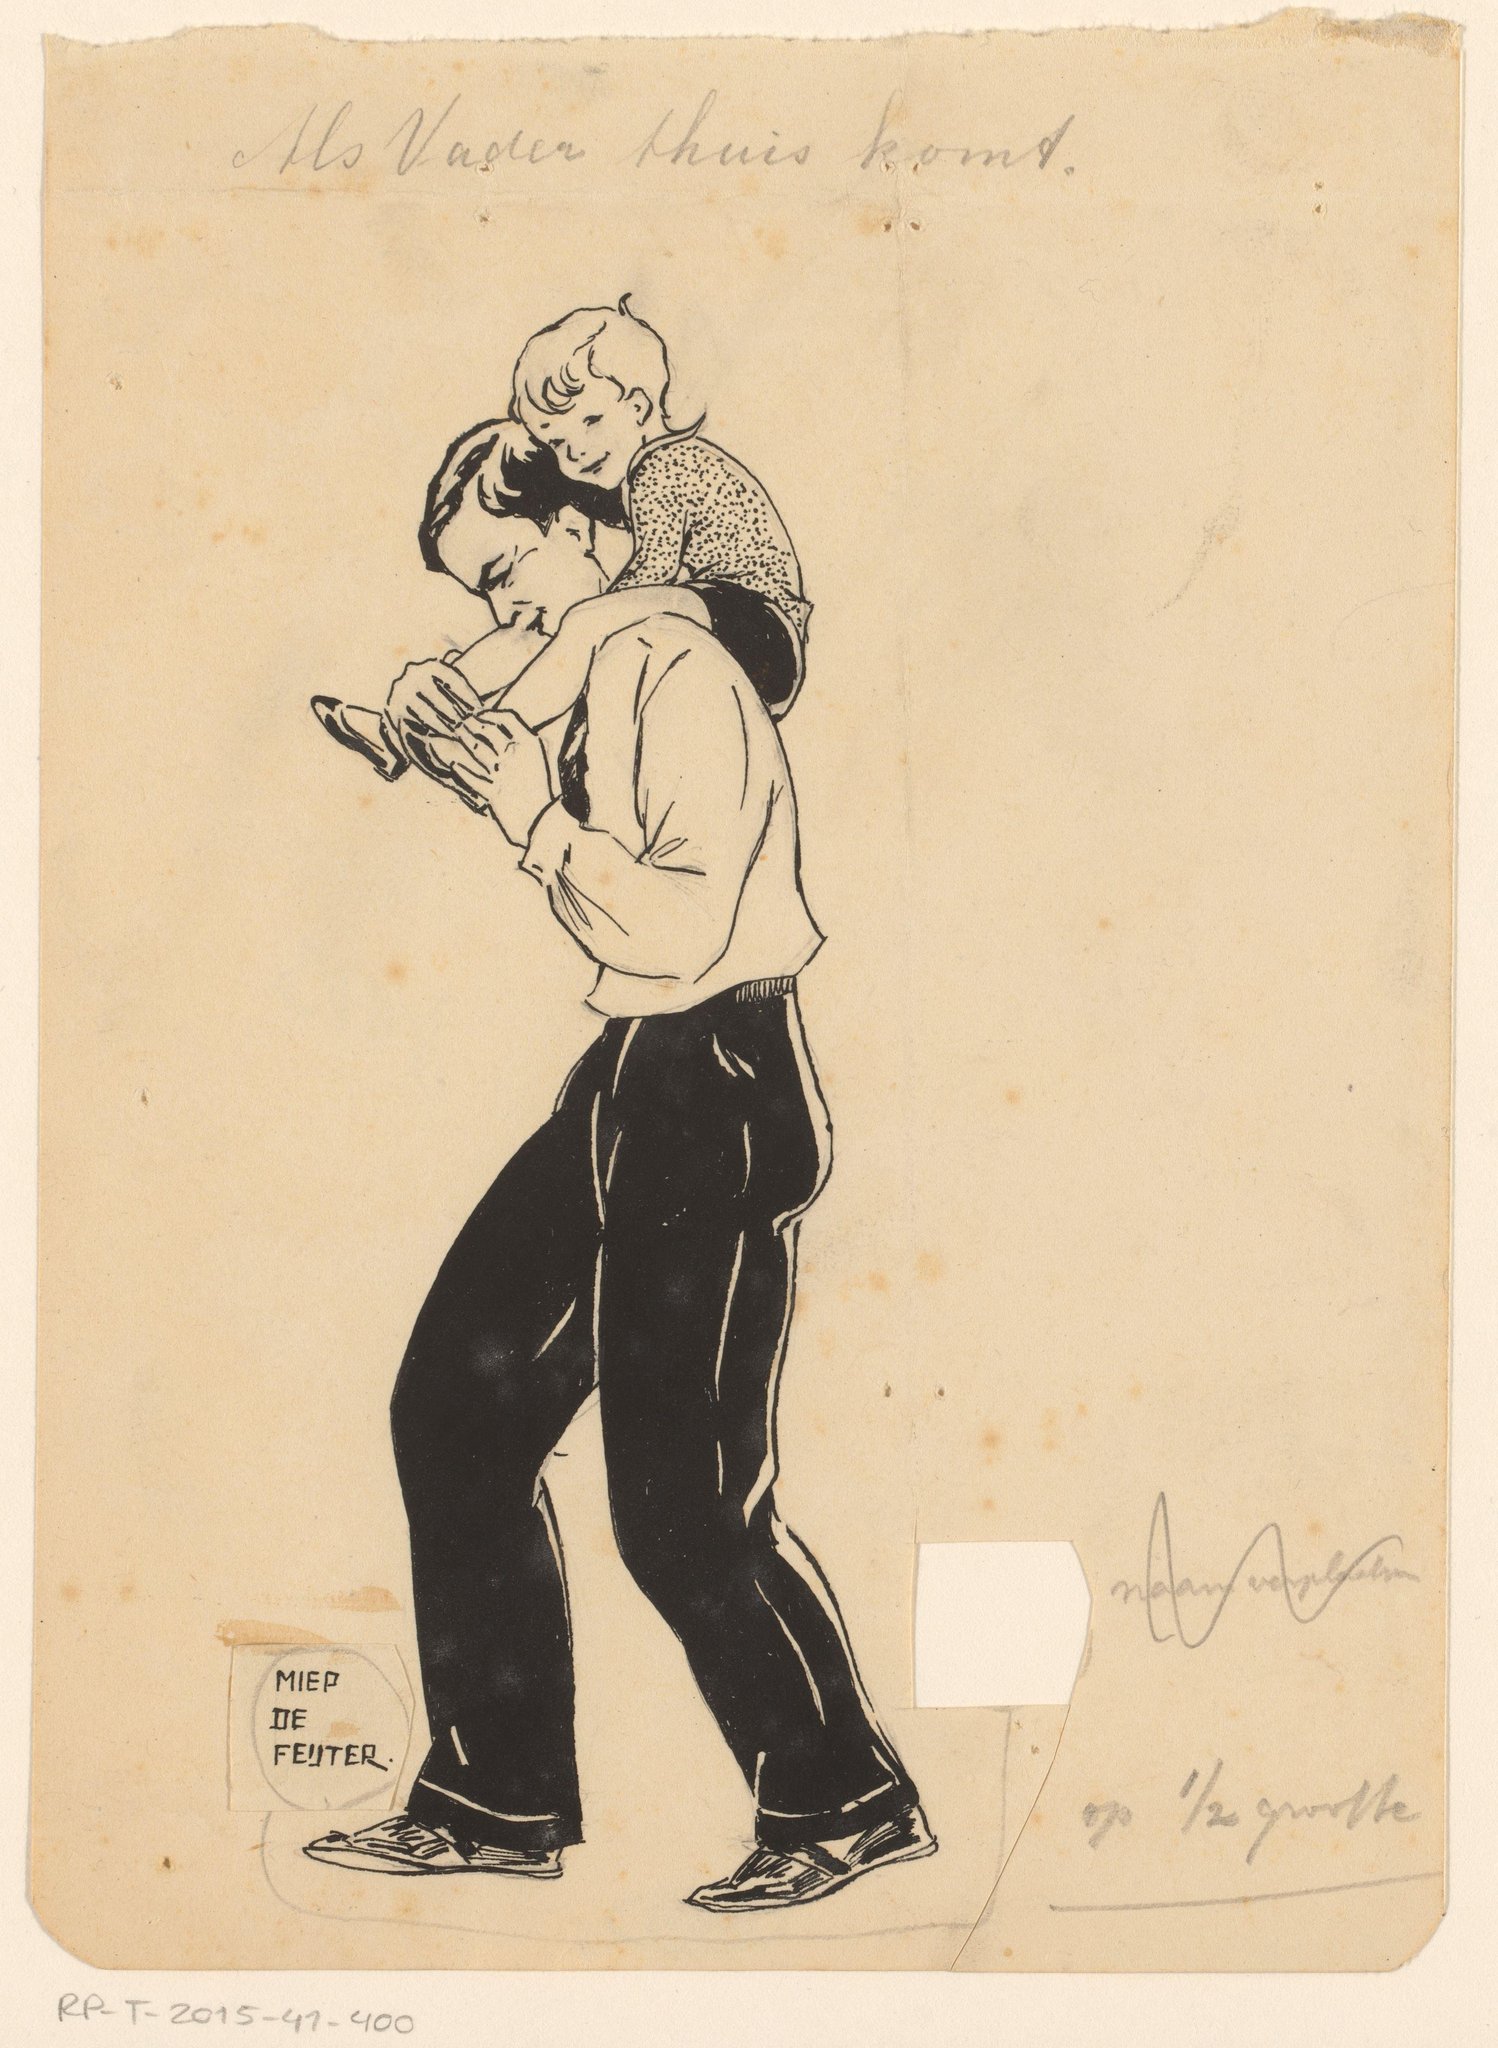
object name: boekillustratie ontwerp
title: Vader draagt zijn zoon op de schouders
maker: miep de feijter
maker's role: draughtsman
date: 1928-1941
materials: ink, paper, pencil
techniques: brush, pen, snipping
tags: father and son(s) (family group), carrying a person on one's back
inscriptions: :, collector's mark: Lugt 2228a, signature: ‘MIEP/ DE/ FEIJTER.’, annotation: ‘Als Vader thuis komt./ naam verplaatsen’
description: Een vader gekleed in een broek, overhemd en das en loopt met zijn zoon op zijn schouders. Hij houdt de benen van de jongen vast.